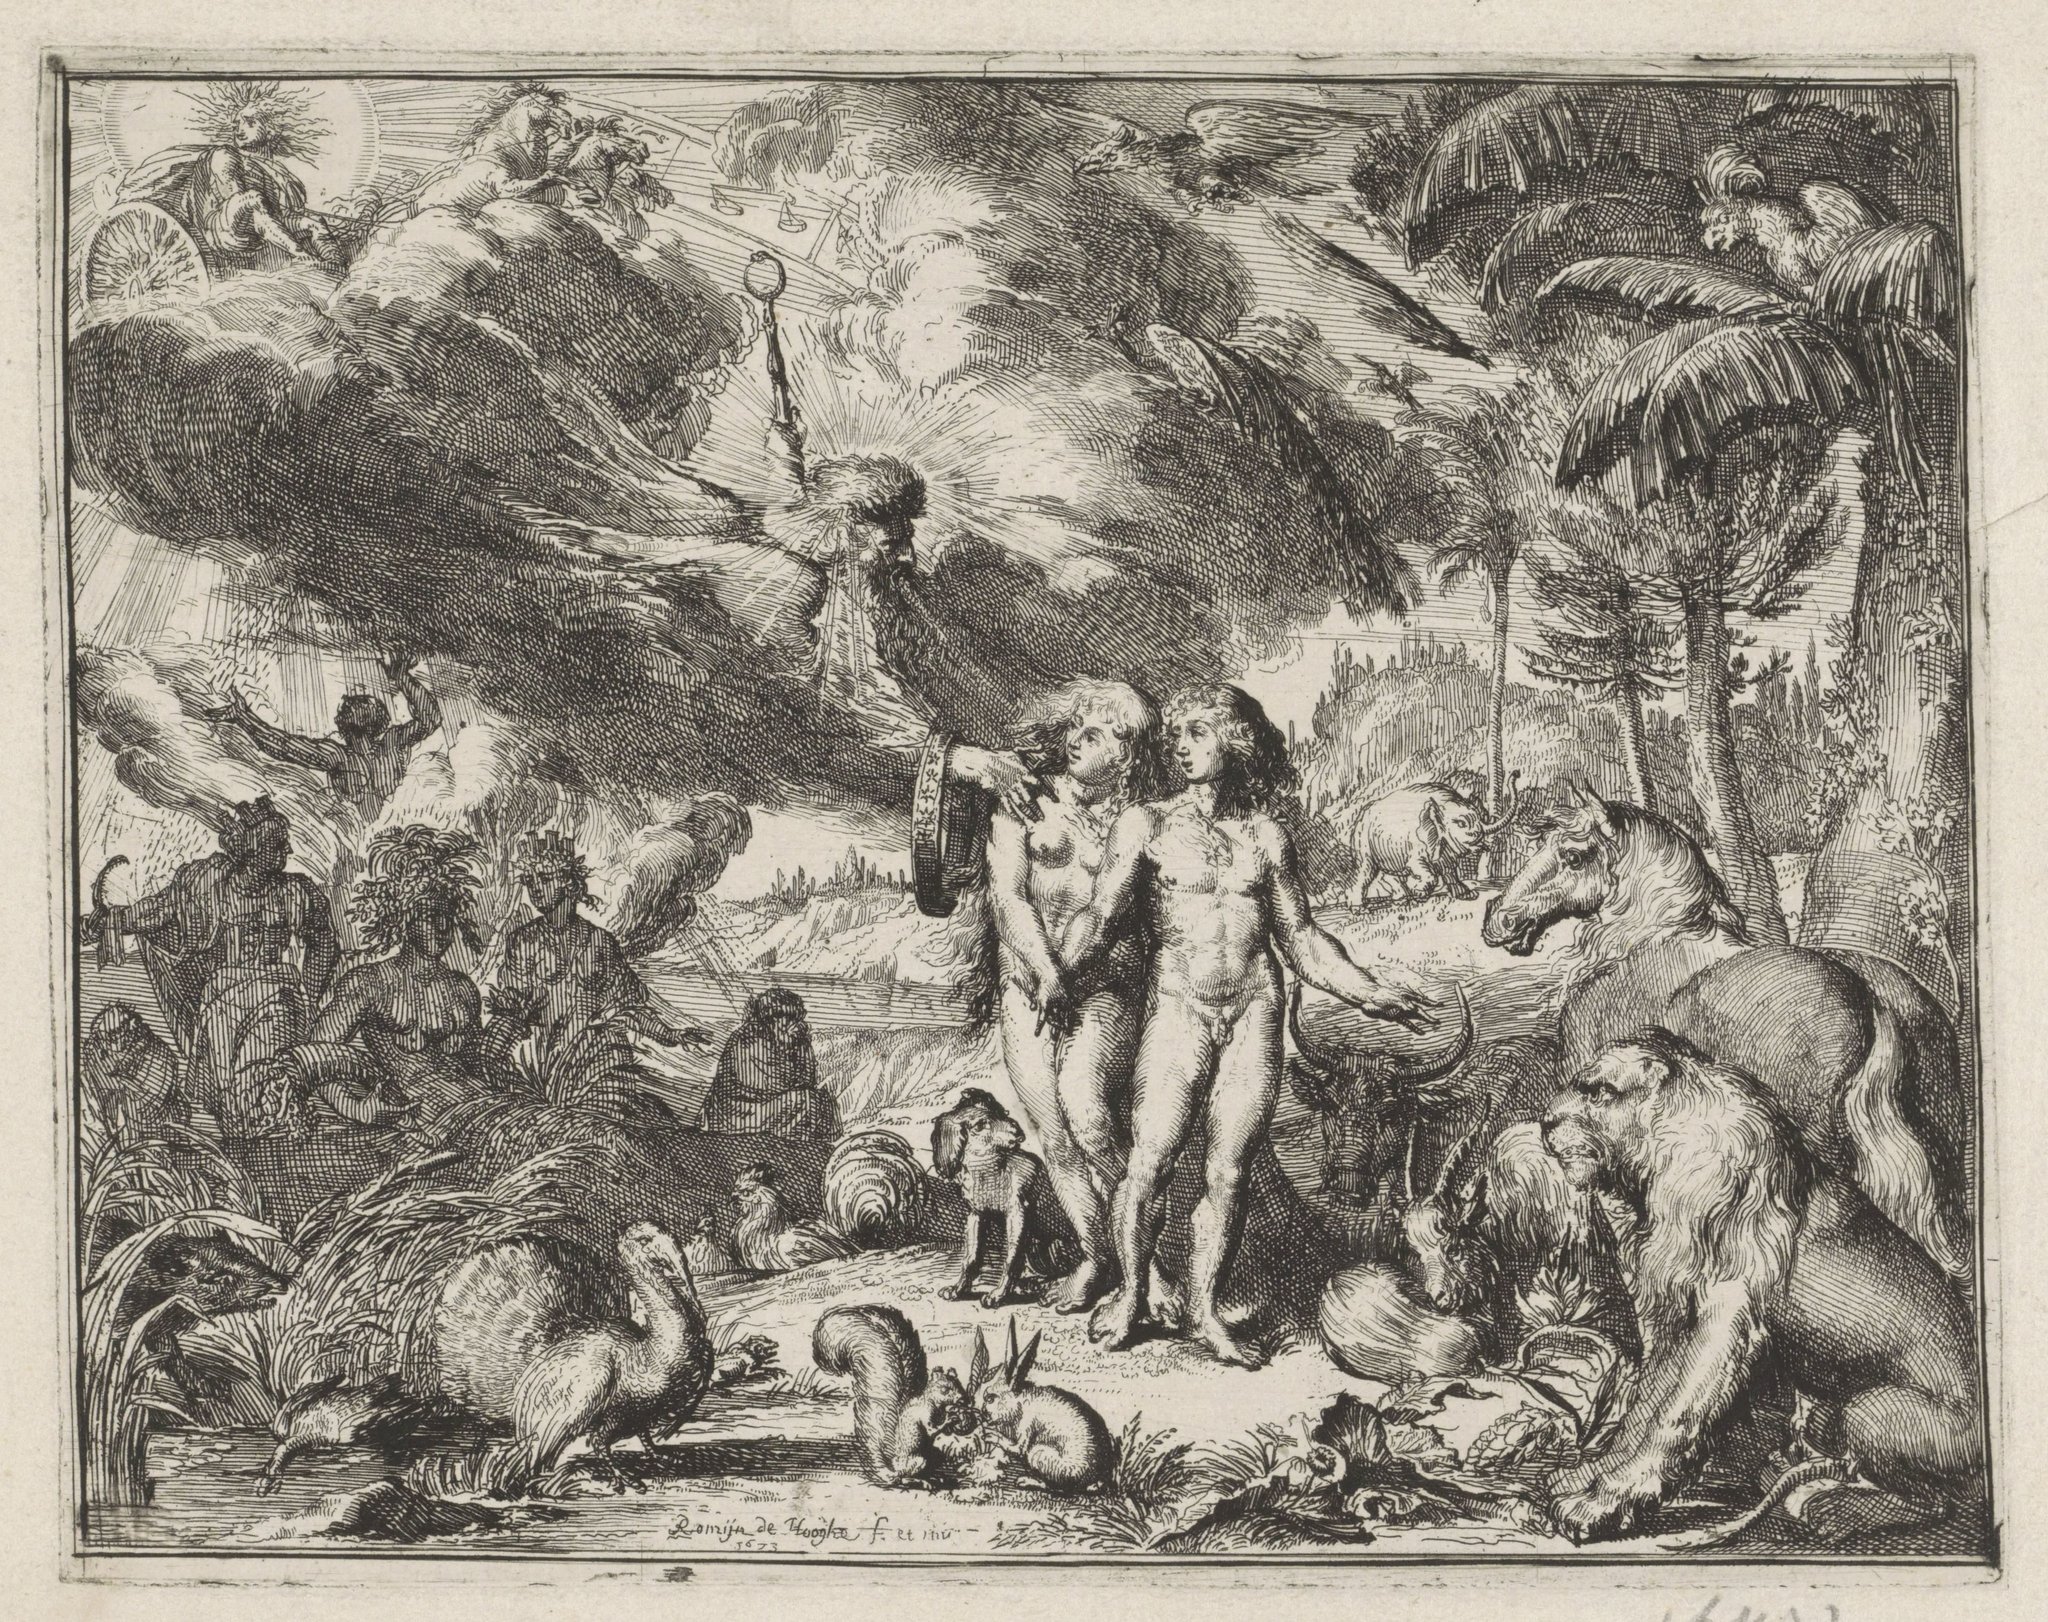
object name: print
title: Adam en Eva in het paradijs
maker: romeyn de hooghe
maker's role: draughtsman, goldsmith, painter, print maker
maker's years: 1645-1708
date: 1673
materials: paper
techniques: etching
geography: amsterdam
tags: adam and eve in paradise (before the fall)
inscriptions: collector's mark: Lugt 2228